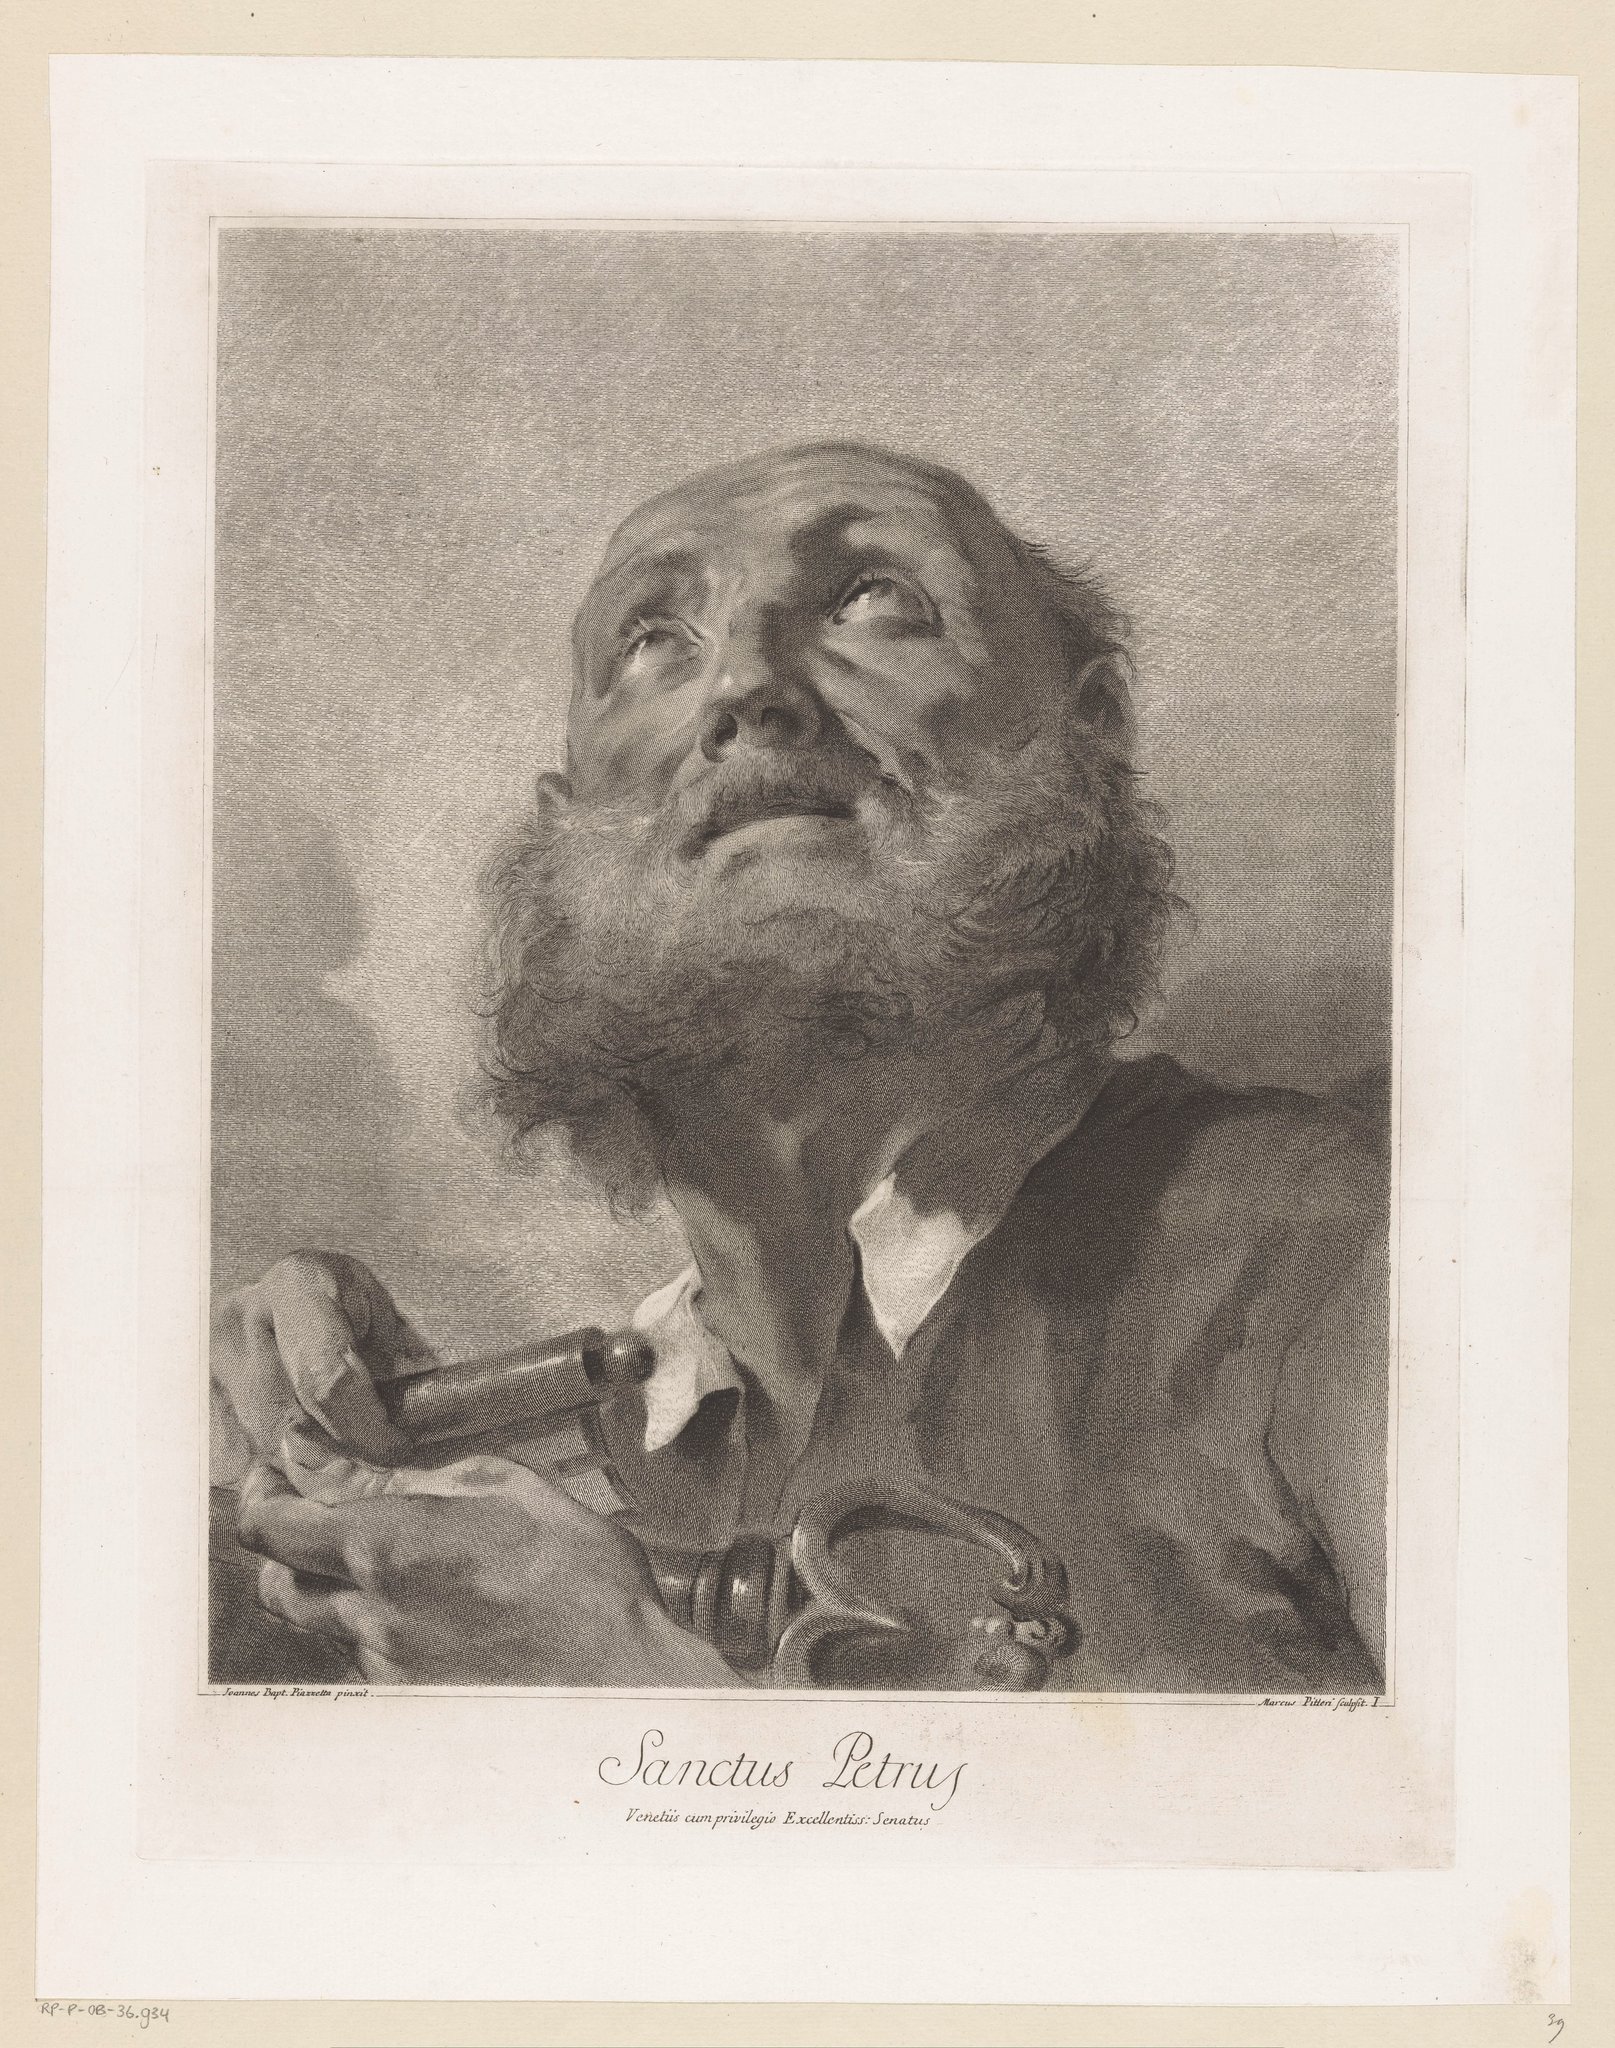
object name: print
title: Apostelen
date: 1712-1786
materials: paper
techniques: engraving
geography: venice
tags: the apostle peter, first bishop of rome; possible attributes: book, cock, (upturned) cross, (triple) crozier, fish, key, scroll, ship, tiara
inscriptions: collector's mark: Lugt 240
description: Deze prent maakt deel uitvan een reeks van 12 prenten.